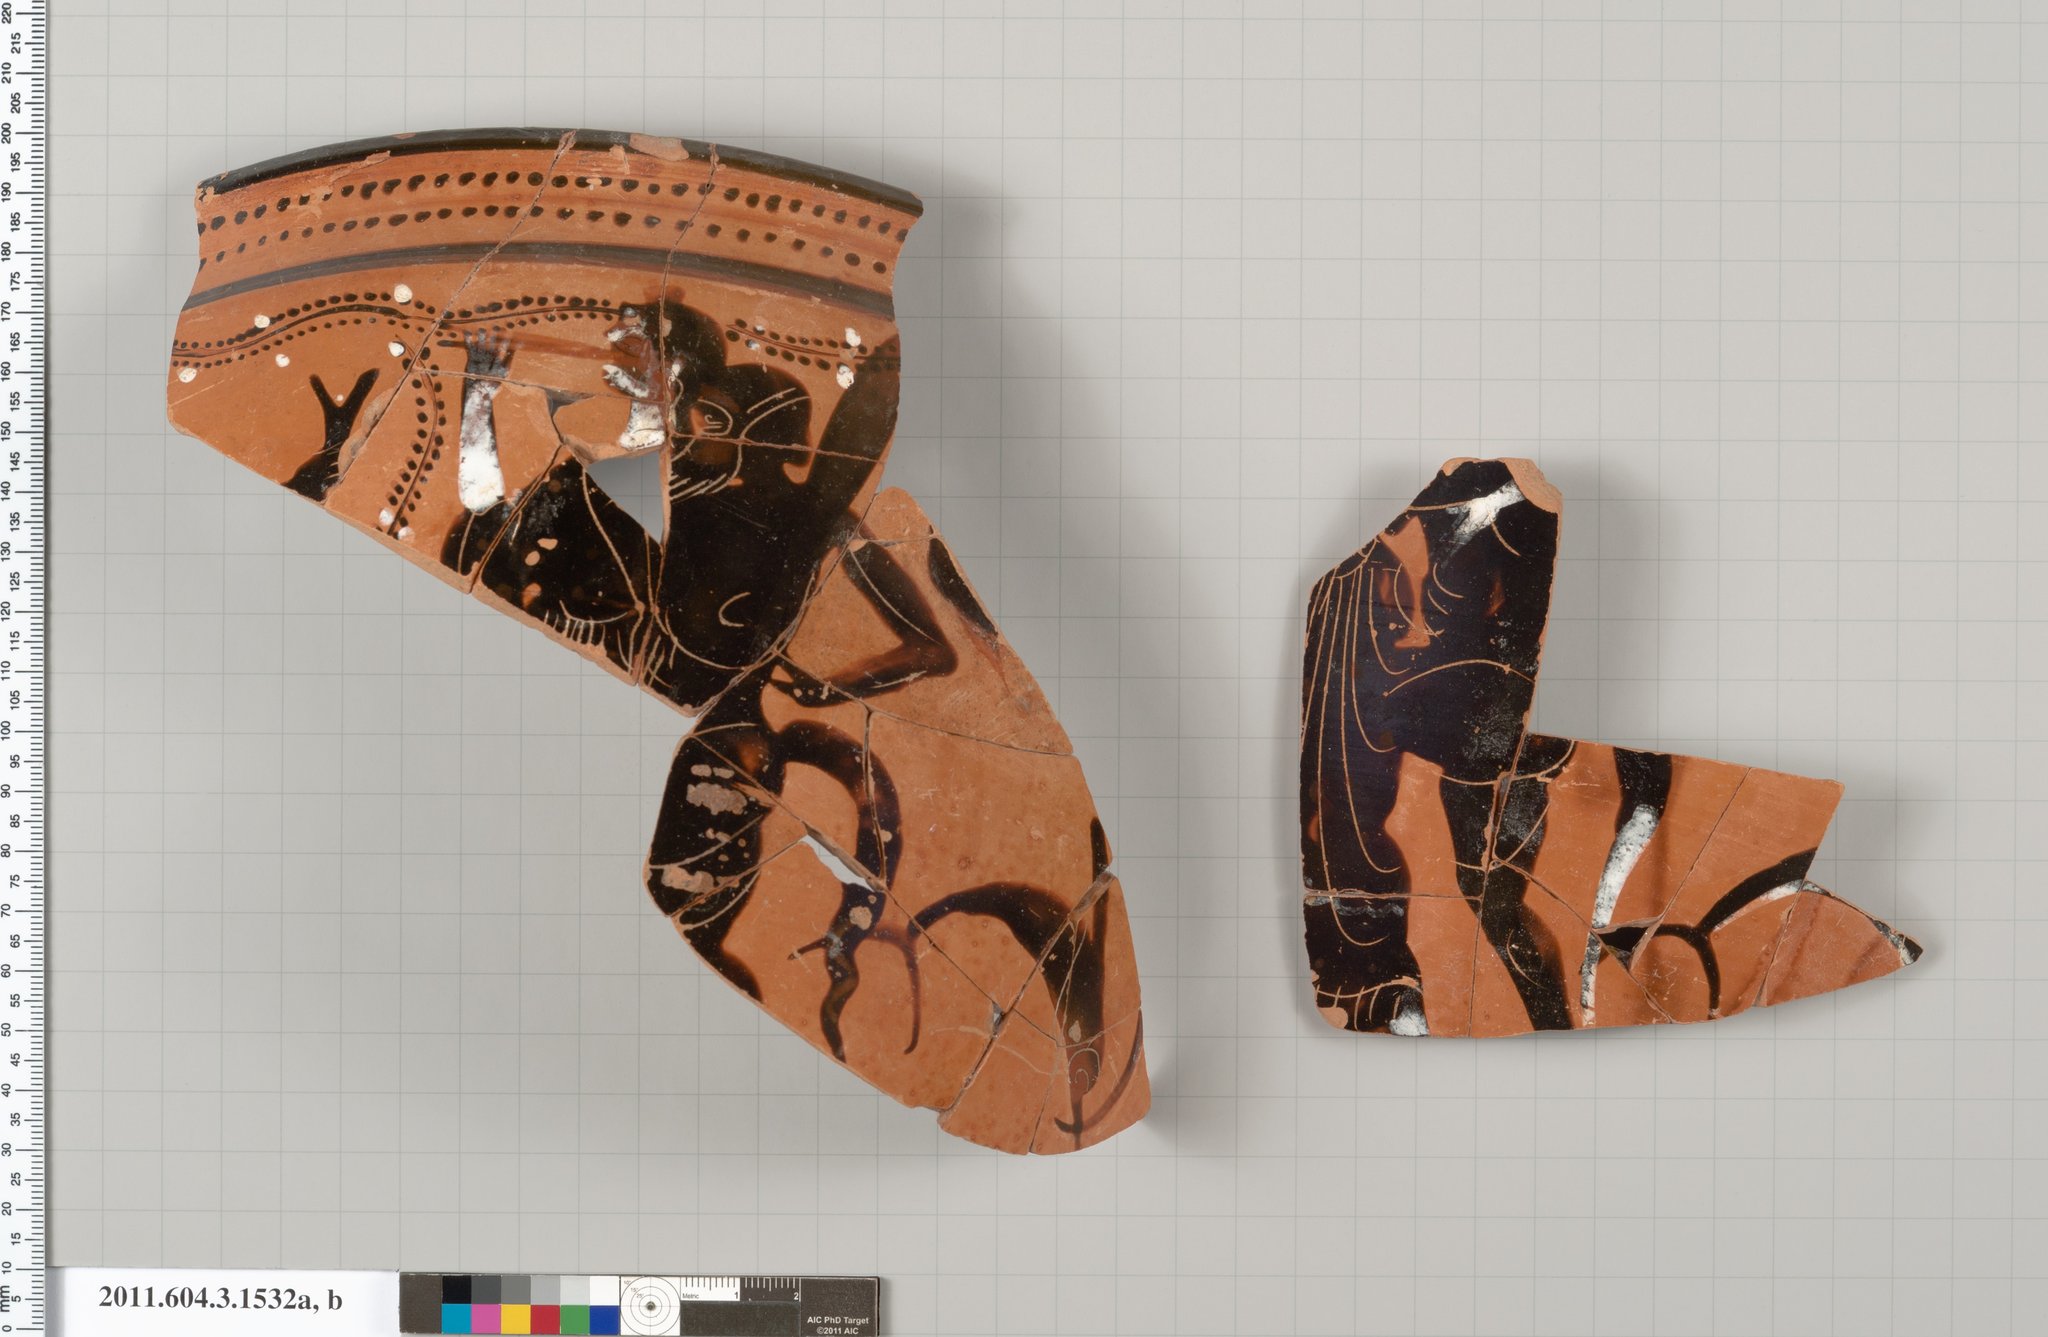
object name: skyphos fragment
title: Terracotta fragments of a skyphos (deep drinking cup)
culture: greek, attic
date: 534-468 BCE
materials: terracotta